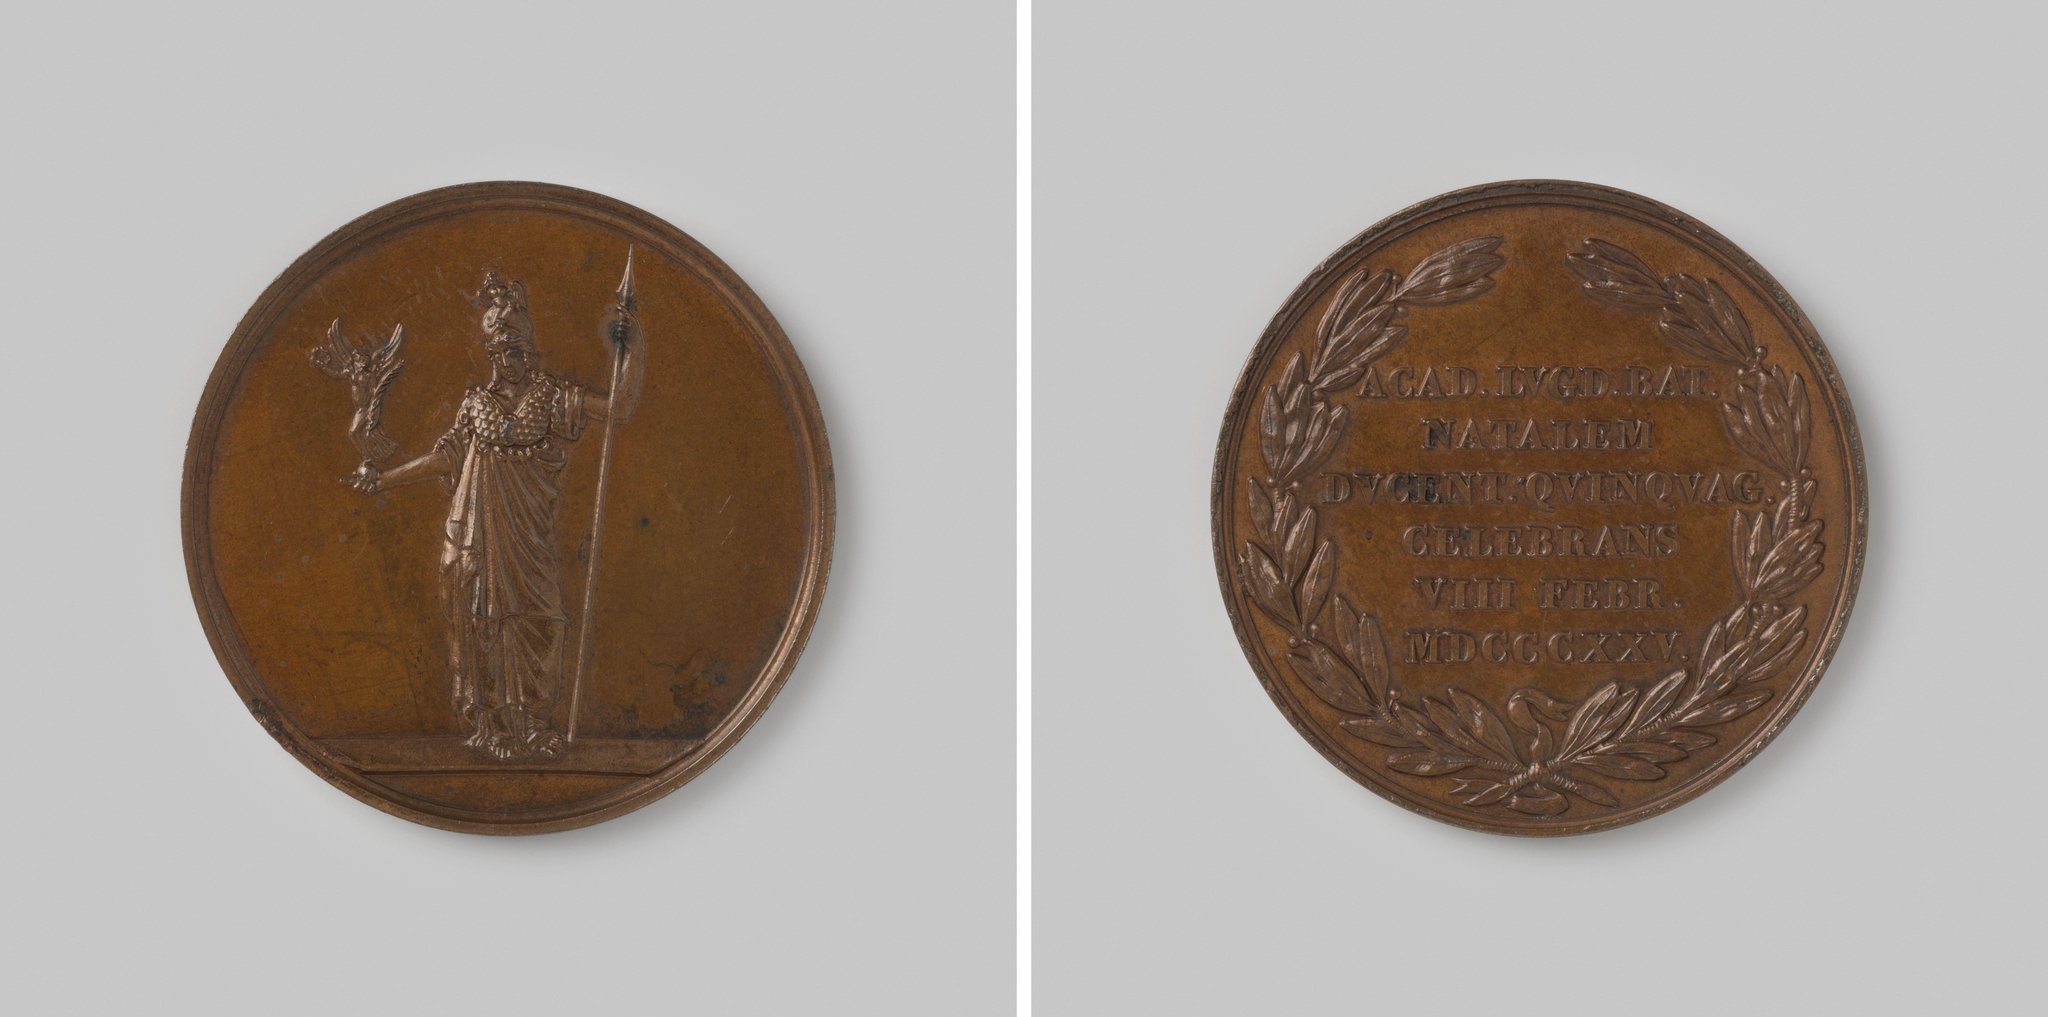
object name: history medal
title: Tweehonderdvijfentwintigjarig bestaan van de Leidsche Hoogeschool 1825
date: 1825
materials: bronze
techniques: striking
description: Bronzen penning, op de voorzijde Minerva staand en face, op de keerzijde zes regels tekst tussen samengestrikte olijftakken.